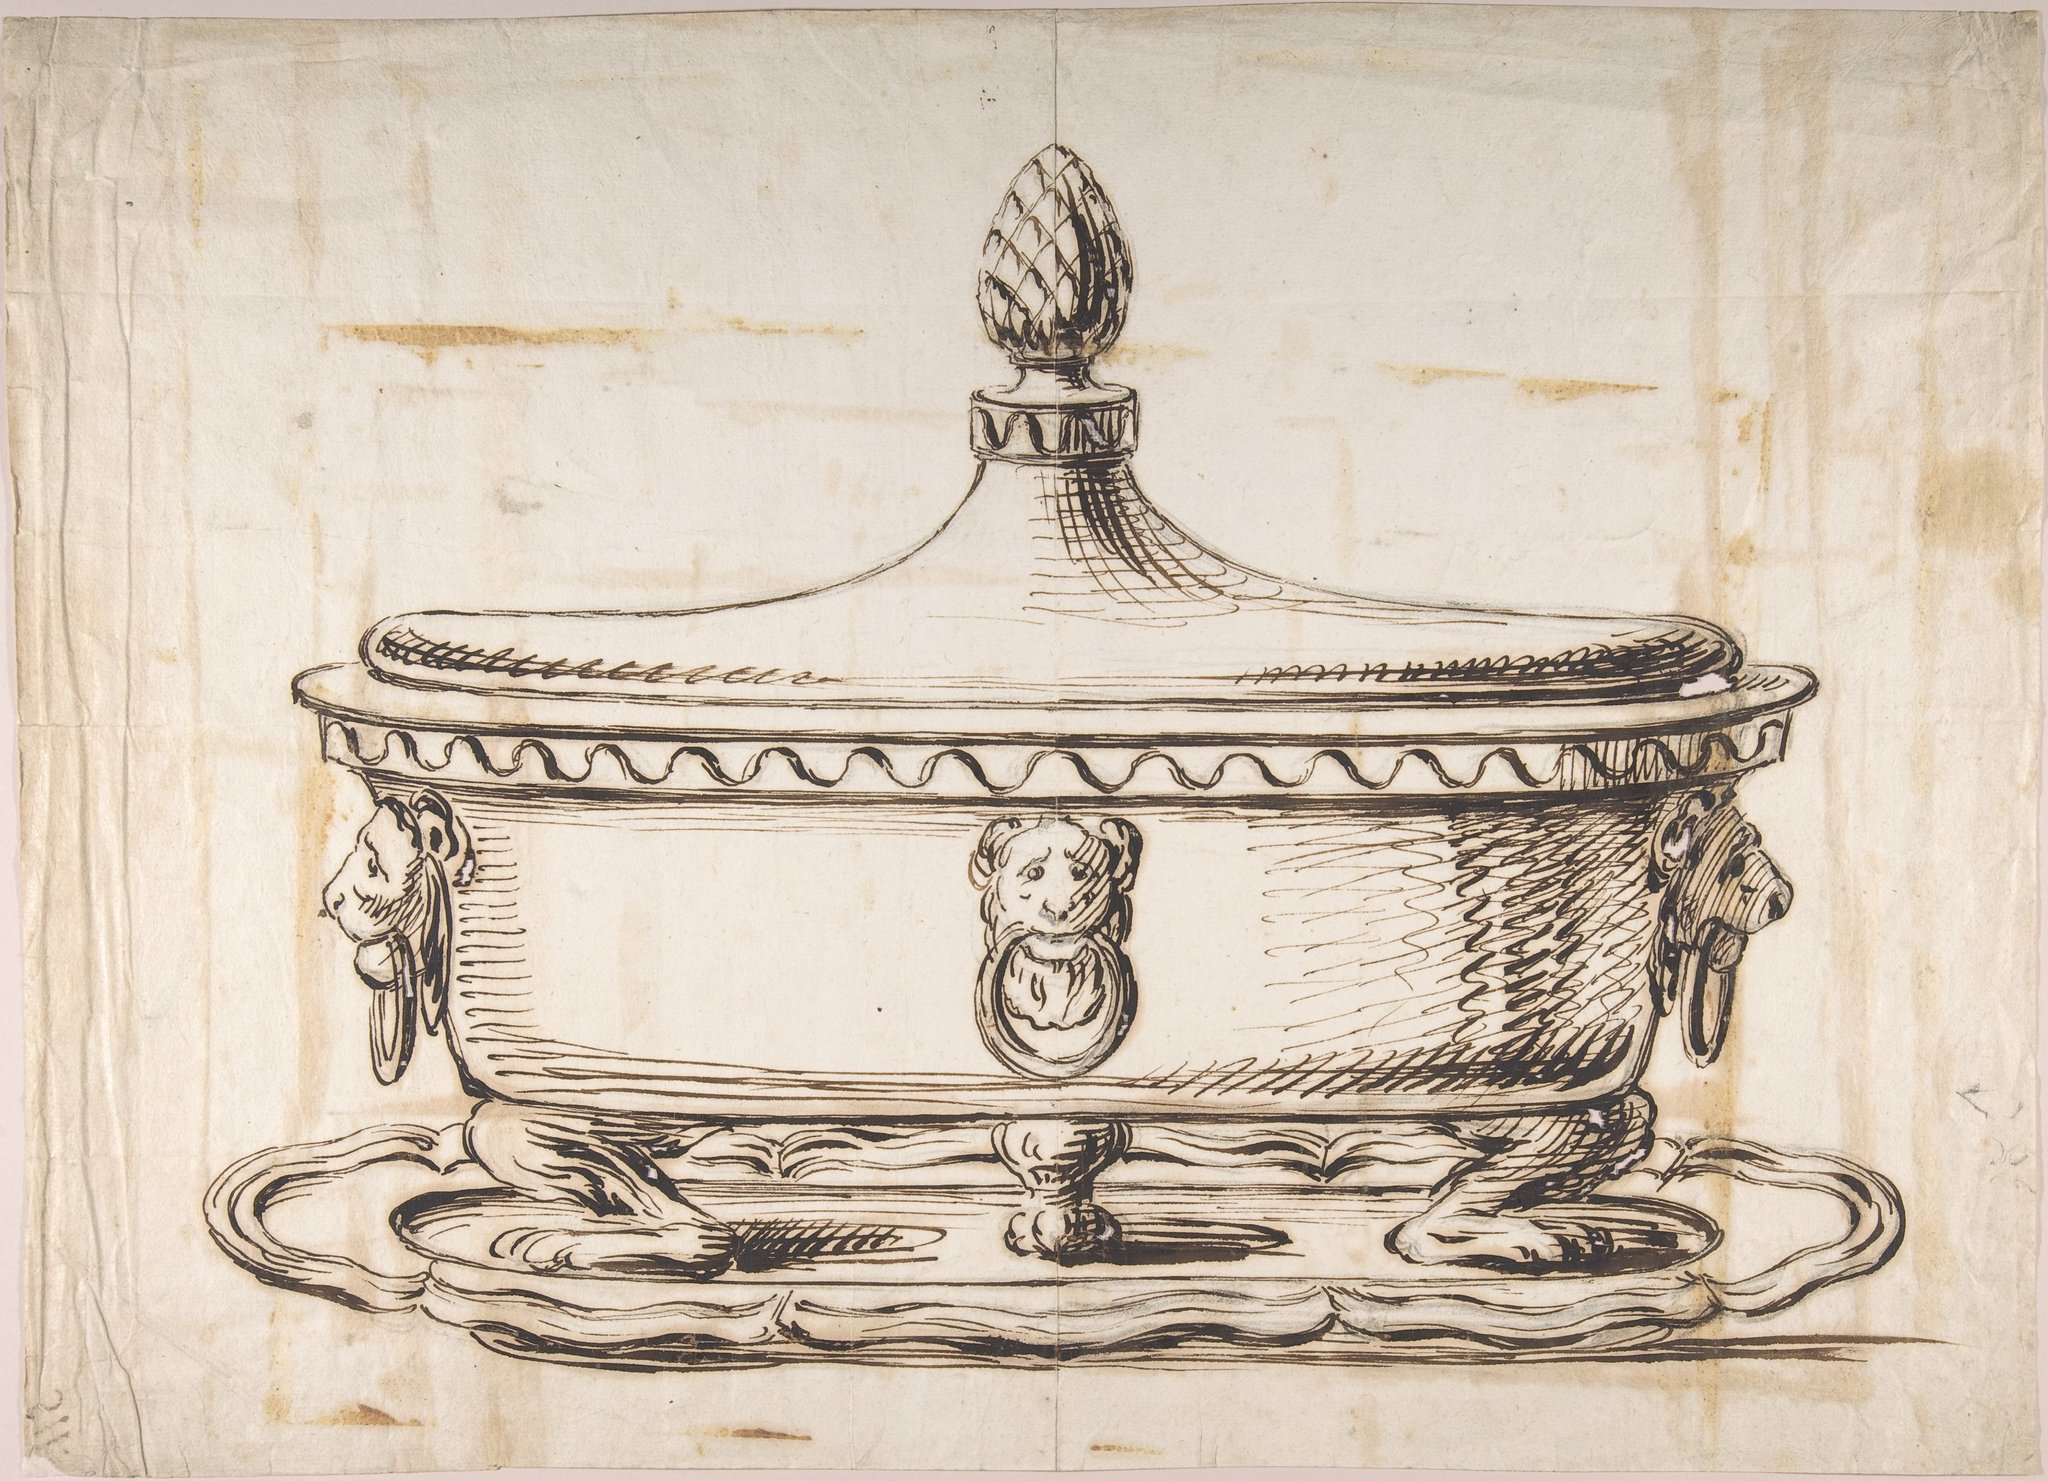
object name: drawing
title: Tureen with Cover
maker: anonymous, italian, 19th century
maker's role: artist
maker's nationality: italian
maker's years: 1800-1900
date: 1801-1900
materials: ink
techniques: pen, wash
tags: tureens